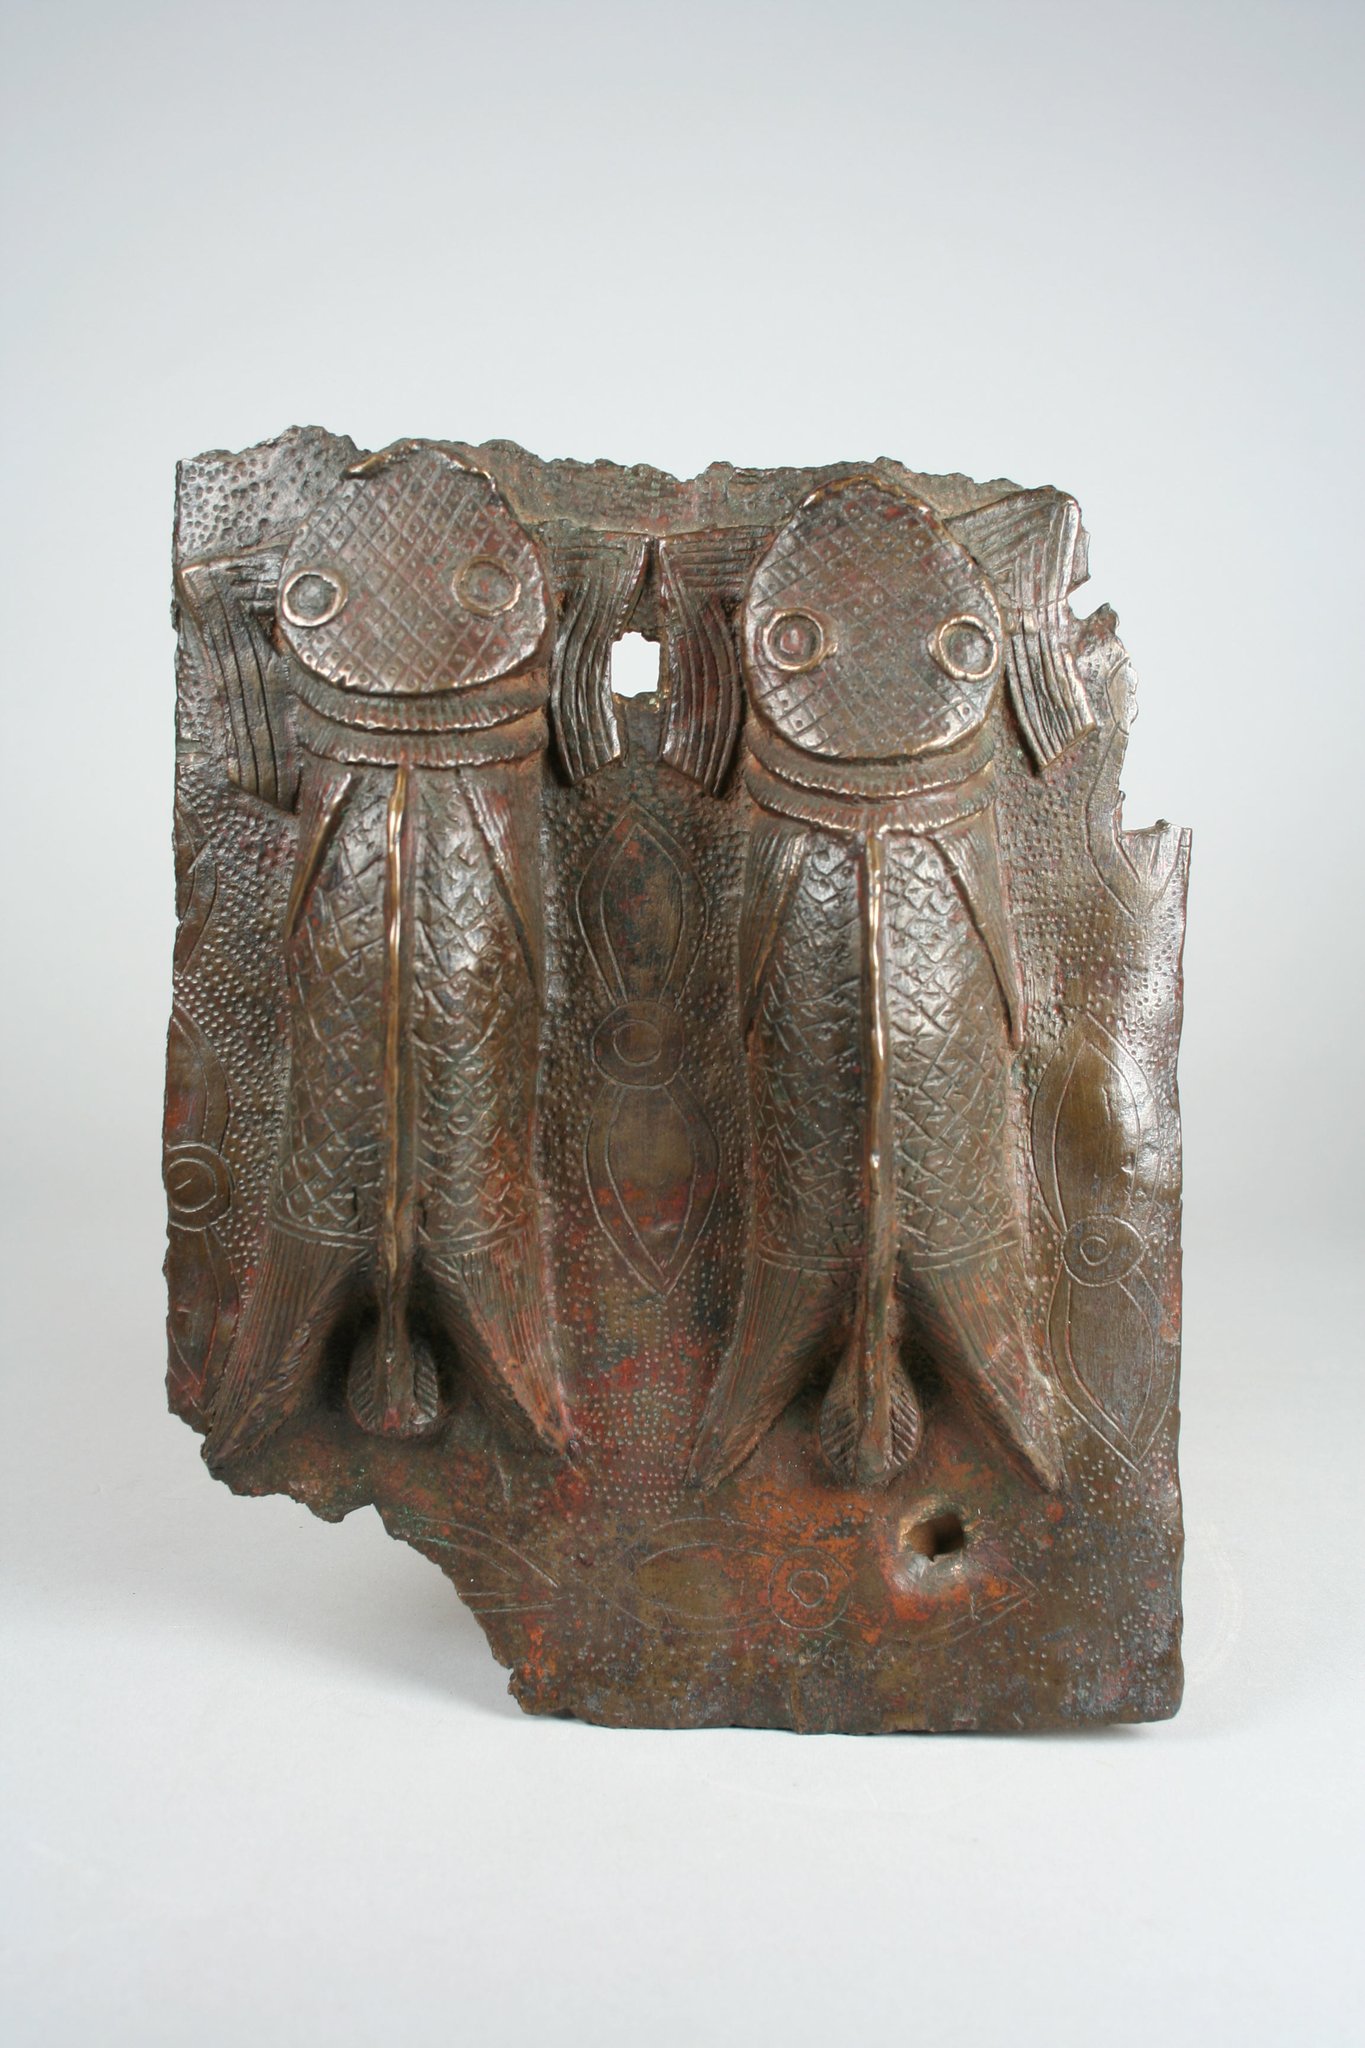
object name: plaque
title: Plaque with Two Mudfish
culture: edo period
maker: ìgùn ẹ́rọ̀nwwọ̀n (brass-casting guild) artists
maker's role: artist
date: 1540-1570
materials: brass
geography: nigeria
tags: fish